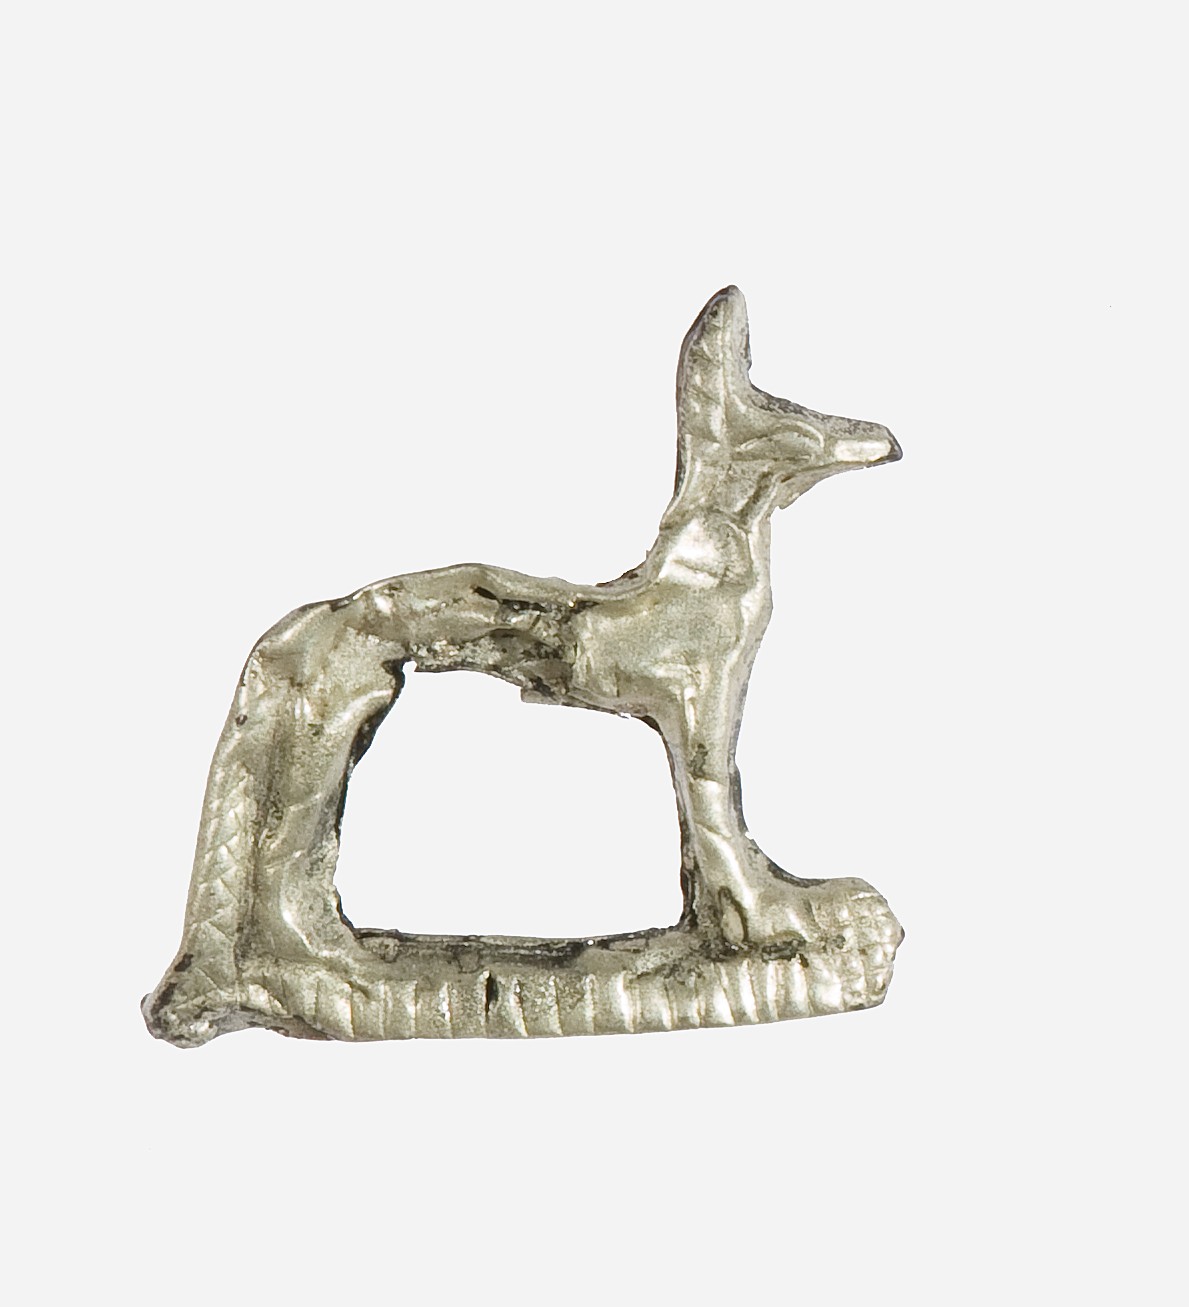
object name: amulet, wepwawet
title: Amulet in the Form of Wepwawet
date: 1850-1775 BCE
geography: egypt